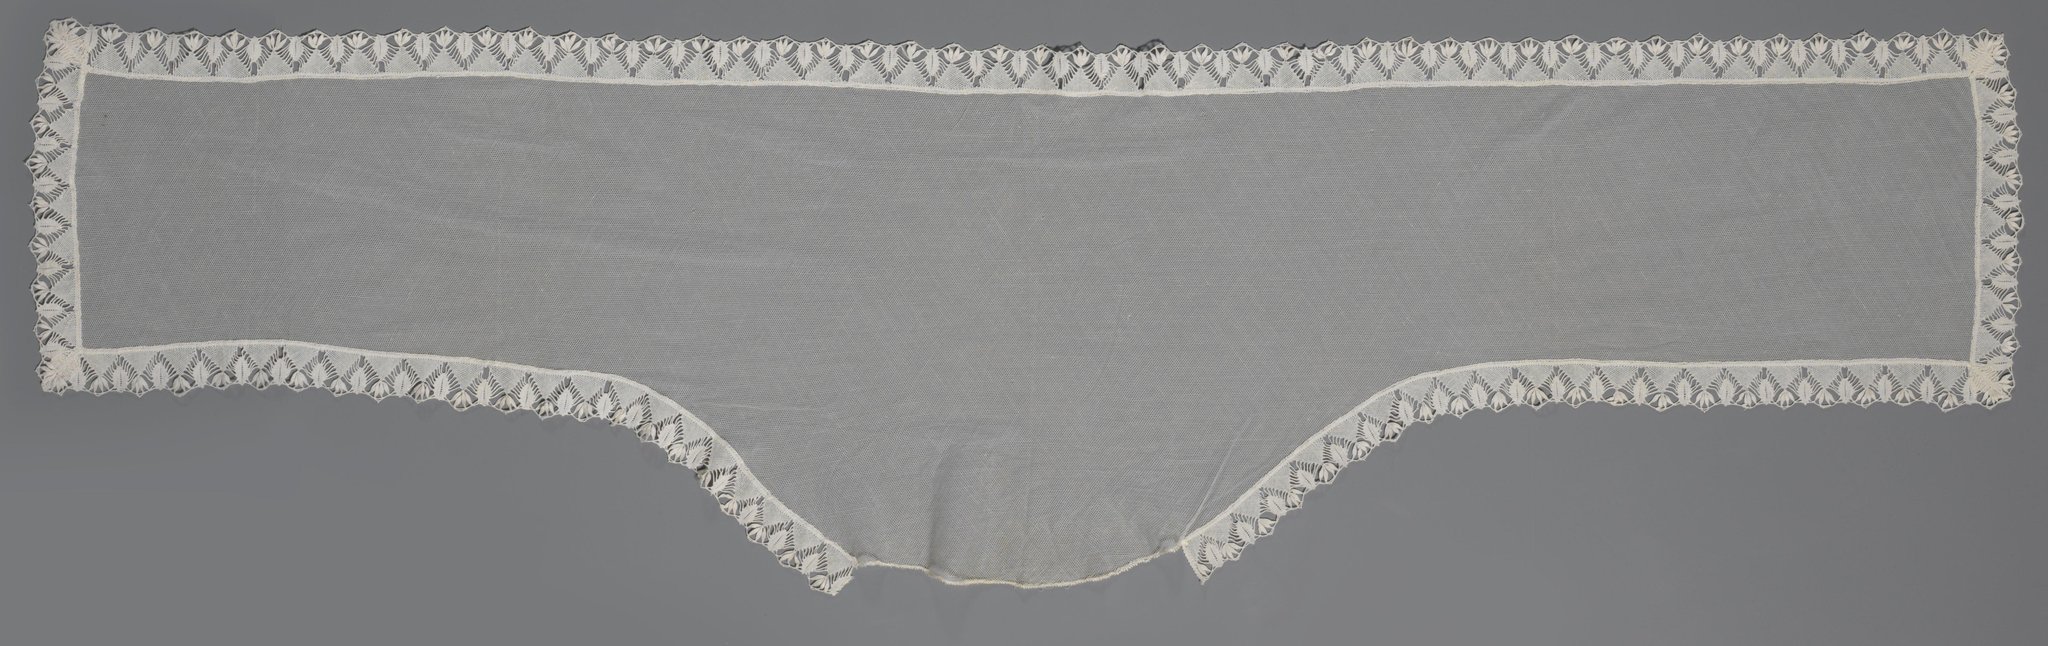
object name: sjaalkraag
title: Sjaalkraag met blaadjesrand van kloskant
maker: wilhelmina cornelia schutten-putters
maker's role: designer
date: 1920-1929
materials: linen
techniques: lace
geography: hellevoetsluis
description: Sjaalkraag met een rand van naturelkleurige kloskant: Cluny-kant. Een tulen middenstuk is aan drie zijden geheel en aan een zijde gedeeltelijk afgezet met een strookje. Dit vertoont een symmetrisch patroon van matte driehoeken met in de zwikken aan talrijke, lange vlechtjes hangende ovaaltjes en in de punten een vierbladerig klokbloempje.